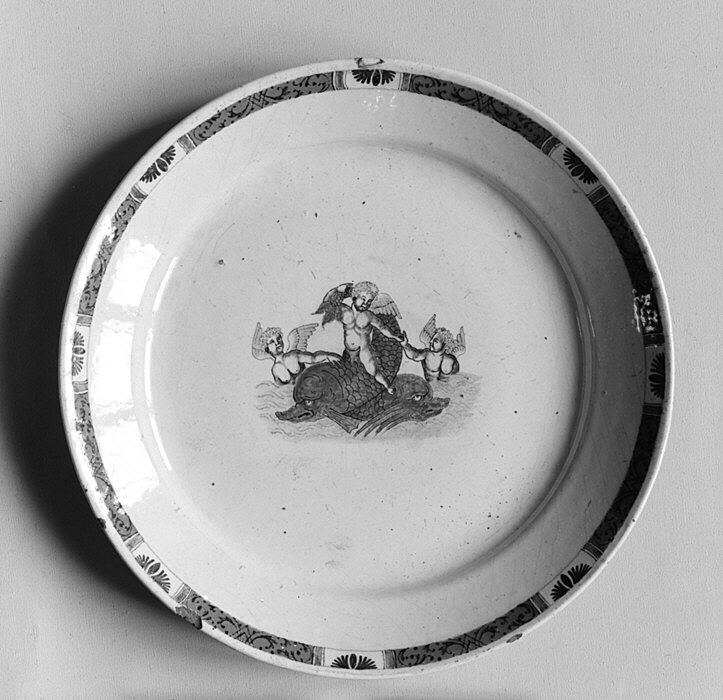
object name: plate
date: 1734-1766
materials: faience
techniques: glazing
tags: putti,dolphins